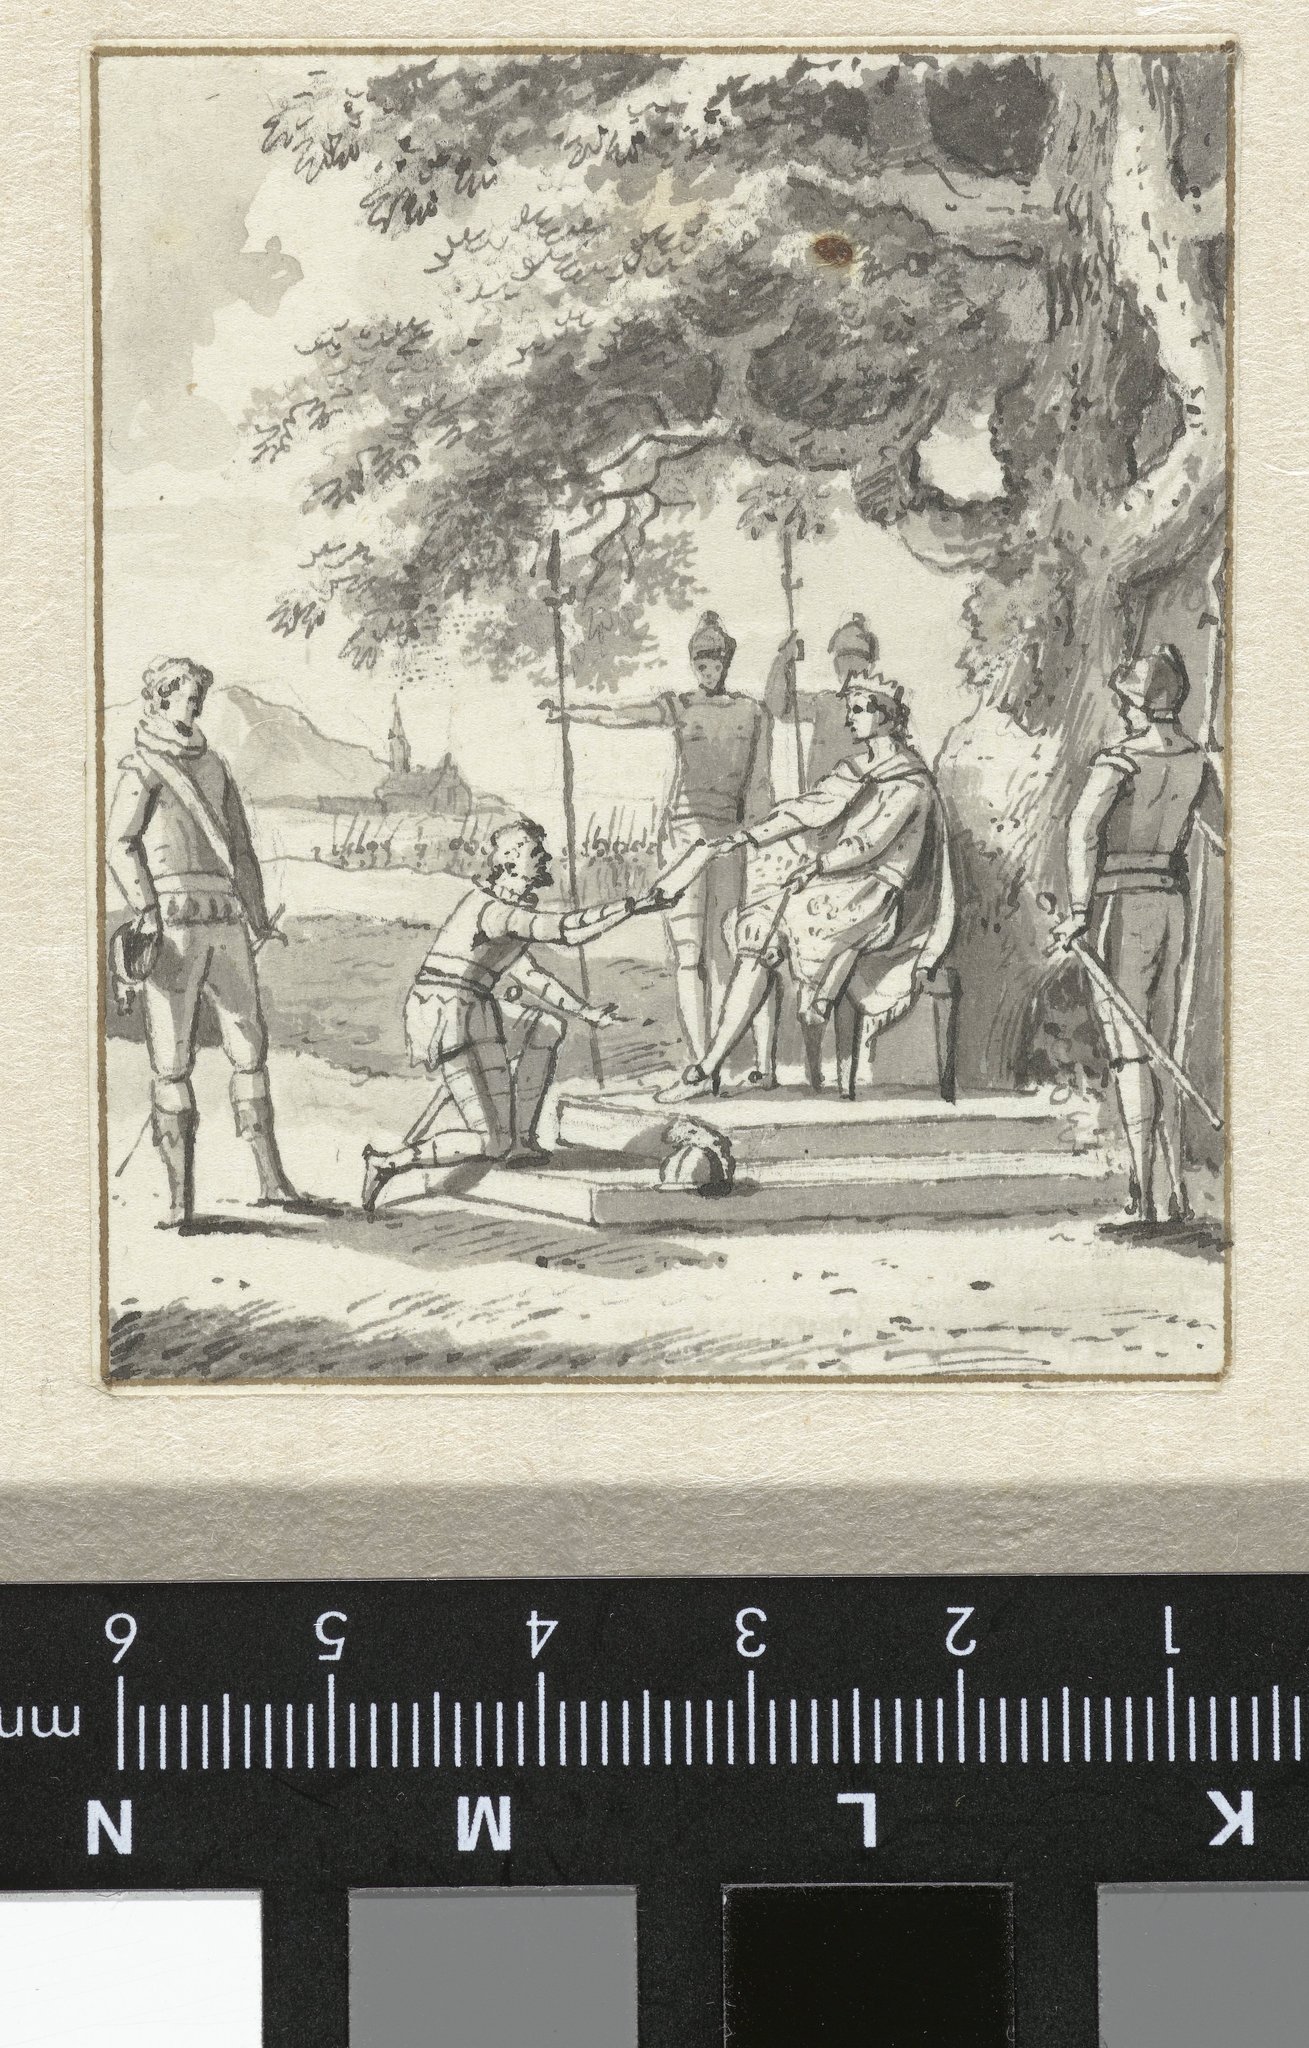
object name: drawing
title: In 't Jaar 923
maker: Anonymous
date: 1789-1810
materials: ink, paper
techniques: brush, pen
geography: netherlands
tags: installation of a ruler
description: Karel de Eenvoudige verleent Dirk I de titel graaf van Holland, 922.